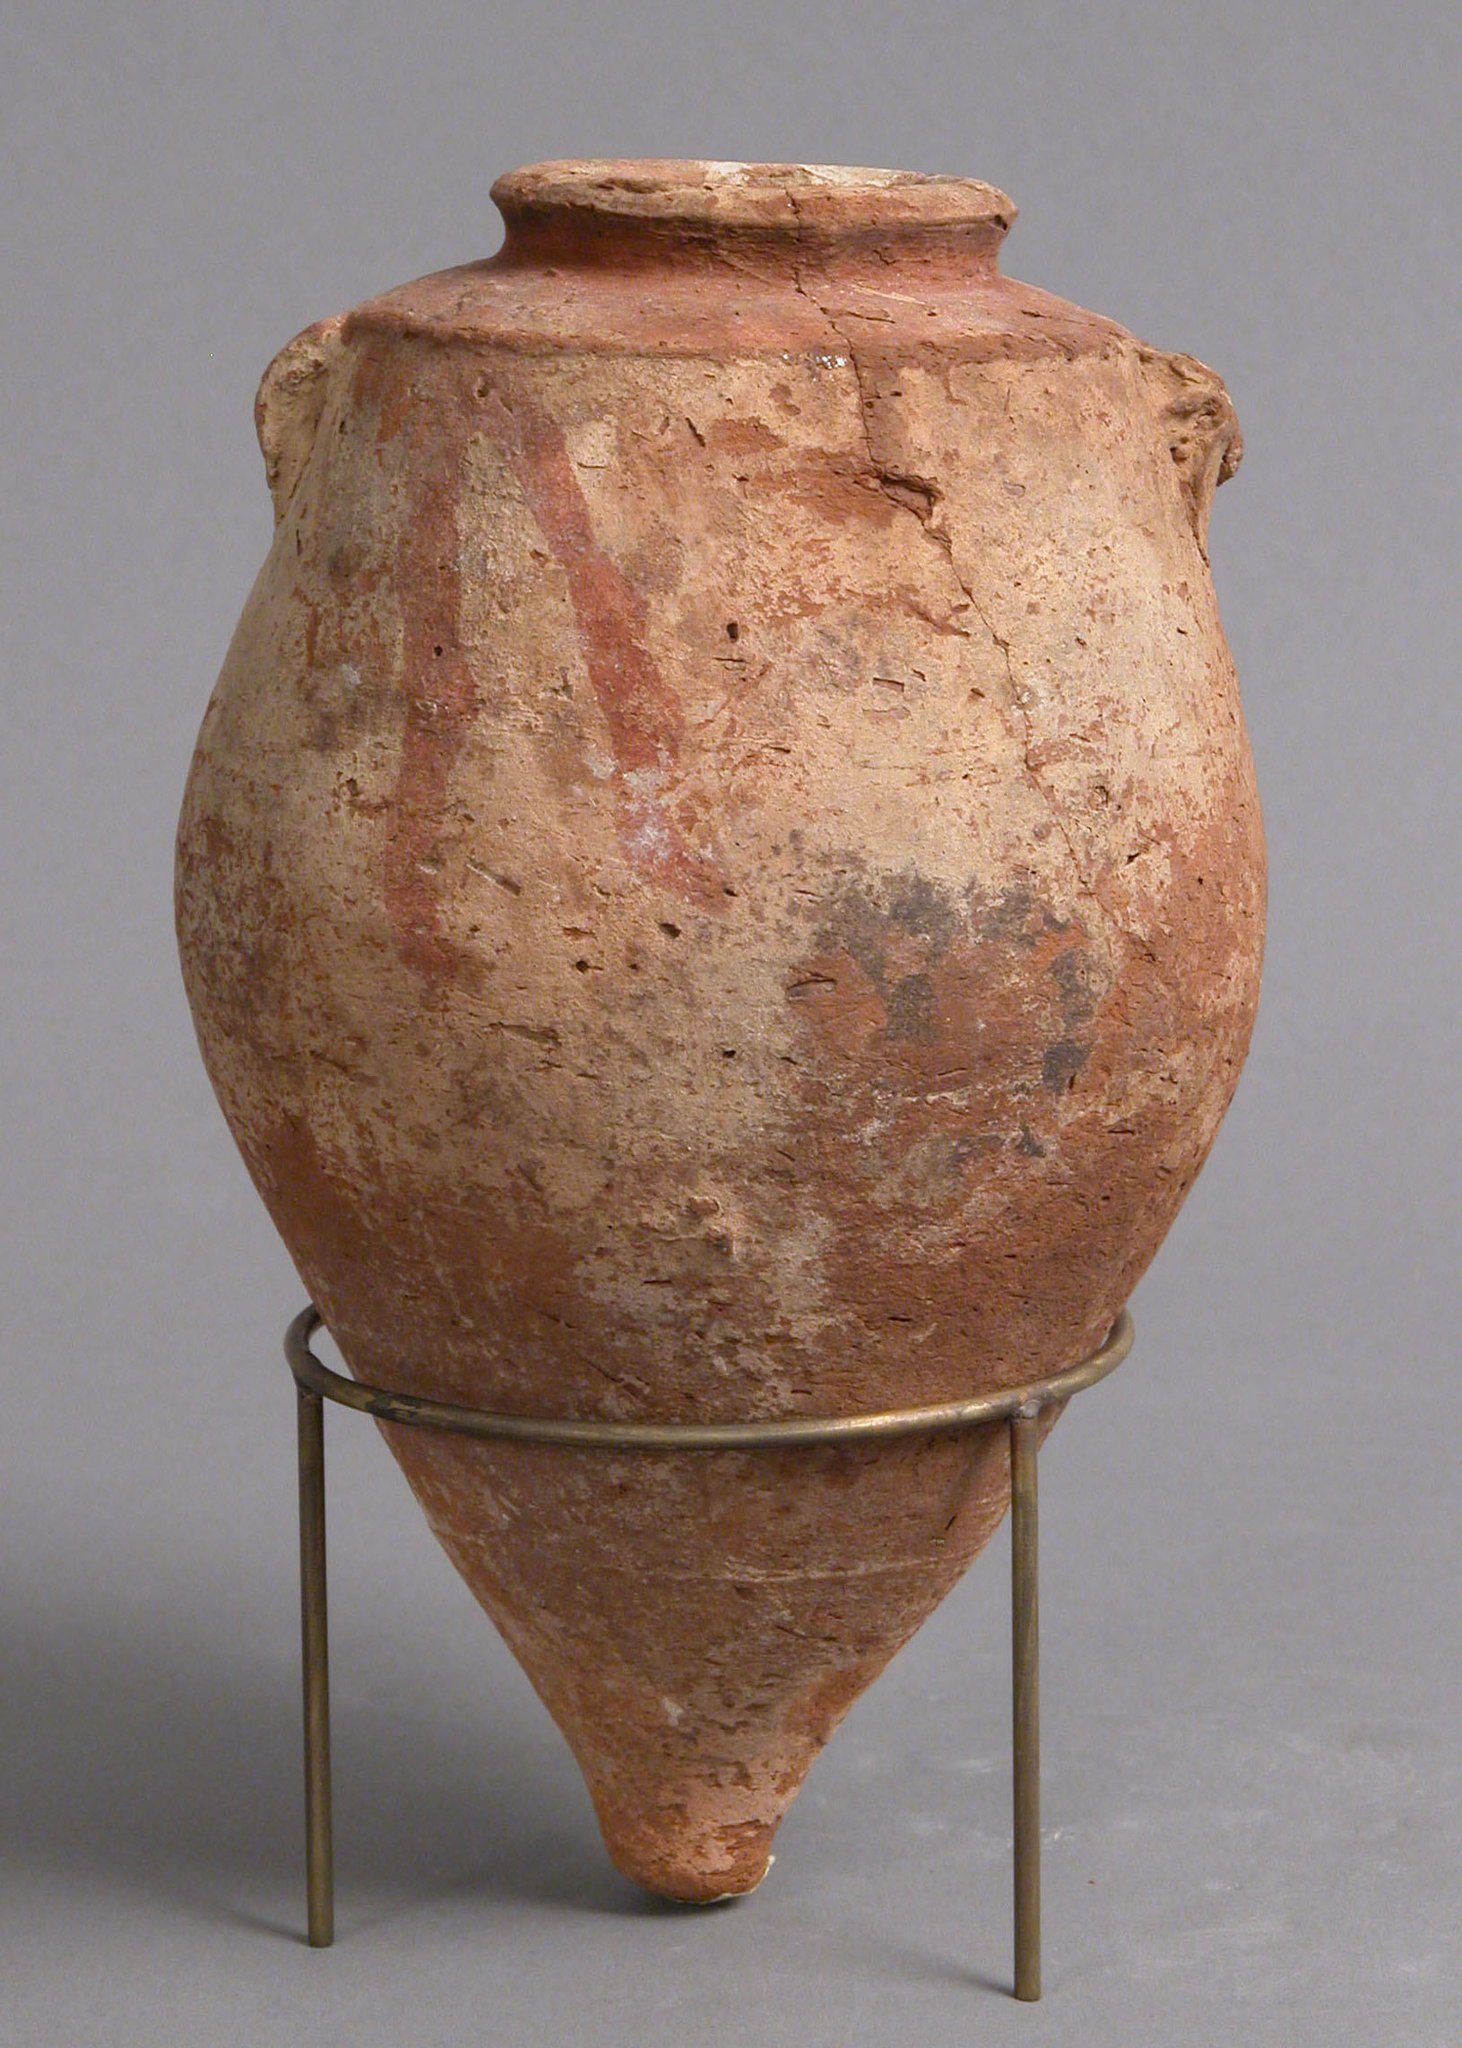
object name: amphora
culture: coptic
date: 301-700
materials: earthenware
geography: egypt